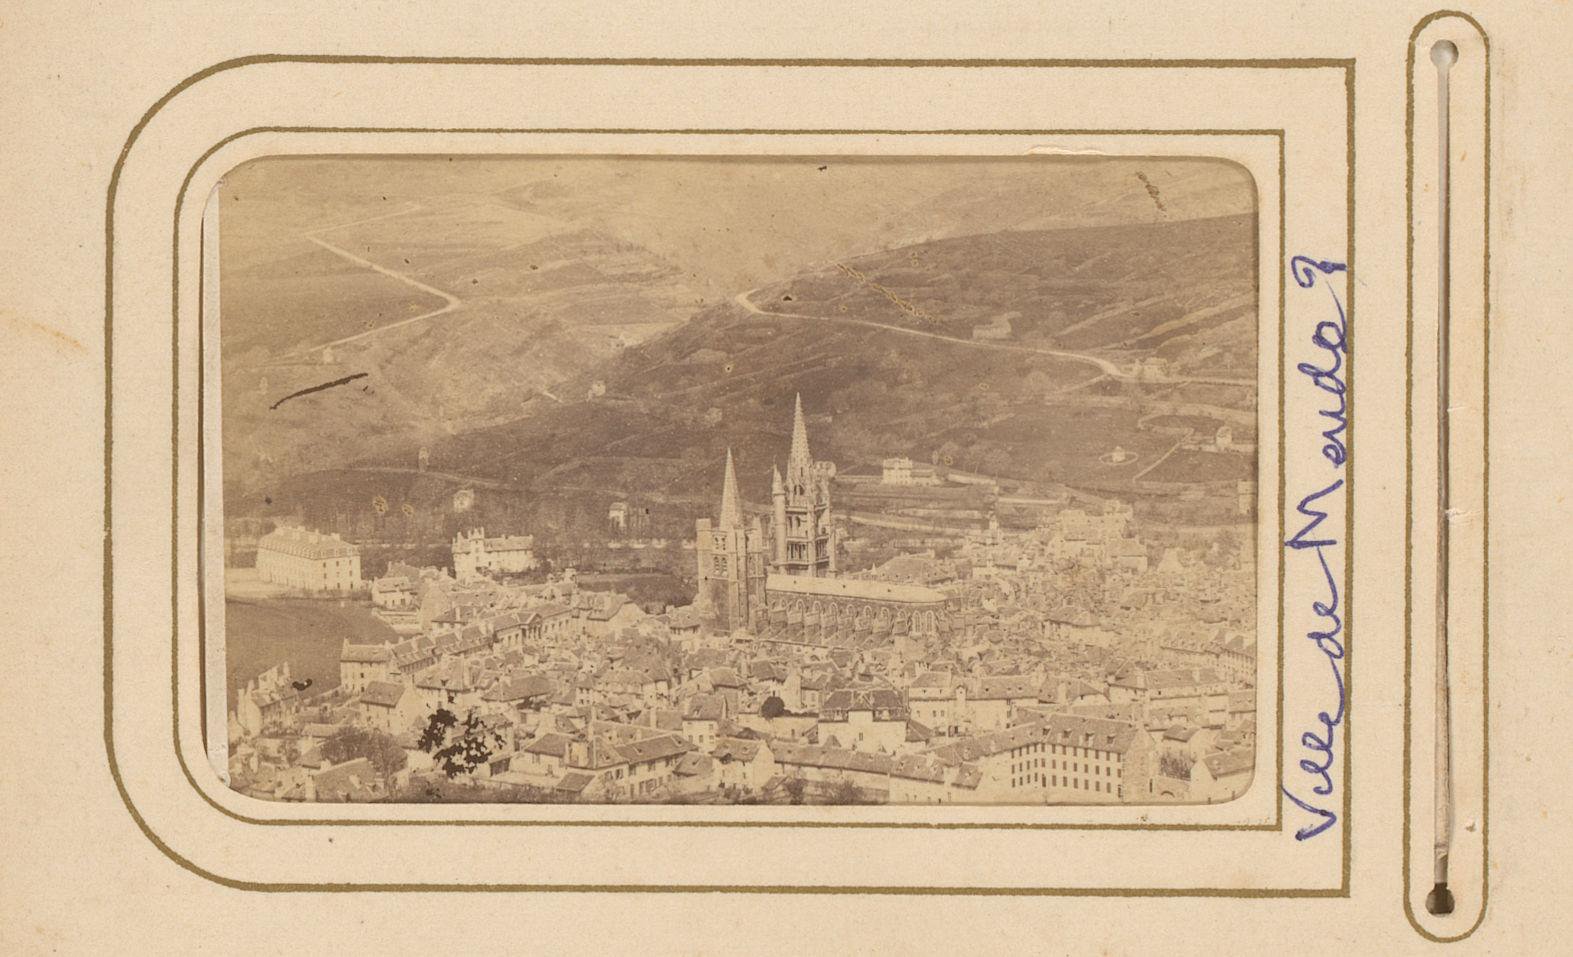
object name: carte de visite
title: Gezicht op Mende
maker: charles pestre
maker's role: fotograaf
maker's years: 1844-1928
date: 1860-1900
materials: cardboard, photographic support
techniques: albumen print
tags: city-view in general; 'veduta', church (exterior)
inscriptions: annotation: ‘Ville de Mende?’, inscription: ‘Ch. Pestre/ Artiste Médaille/ Photographe/ a Mende’